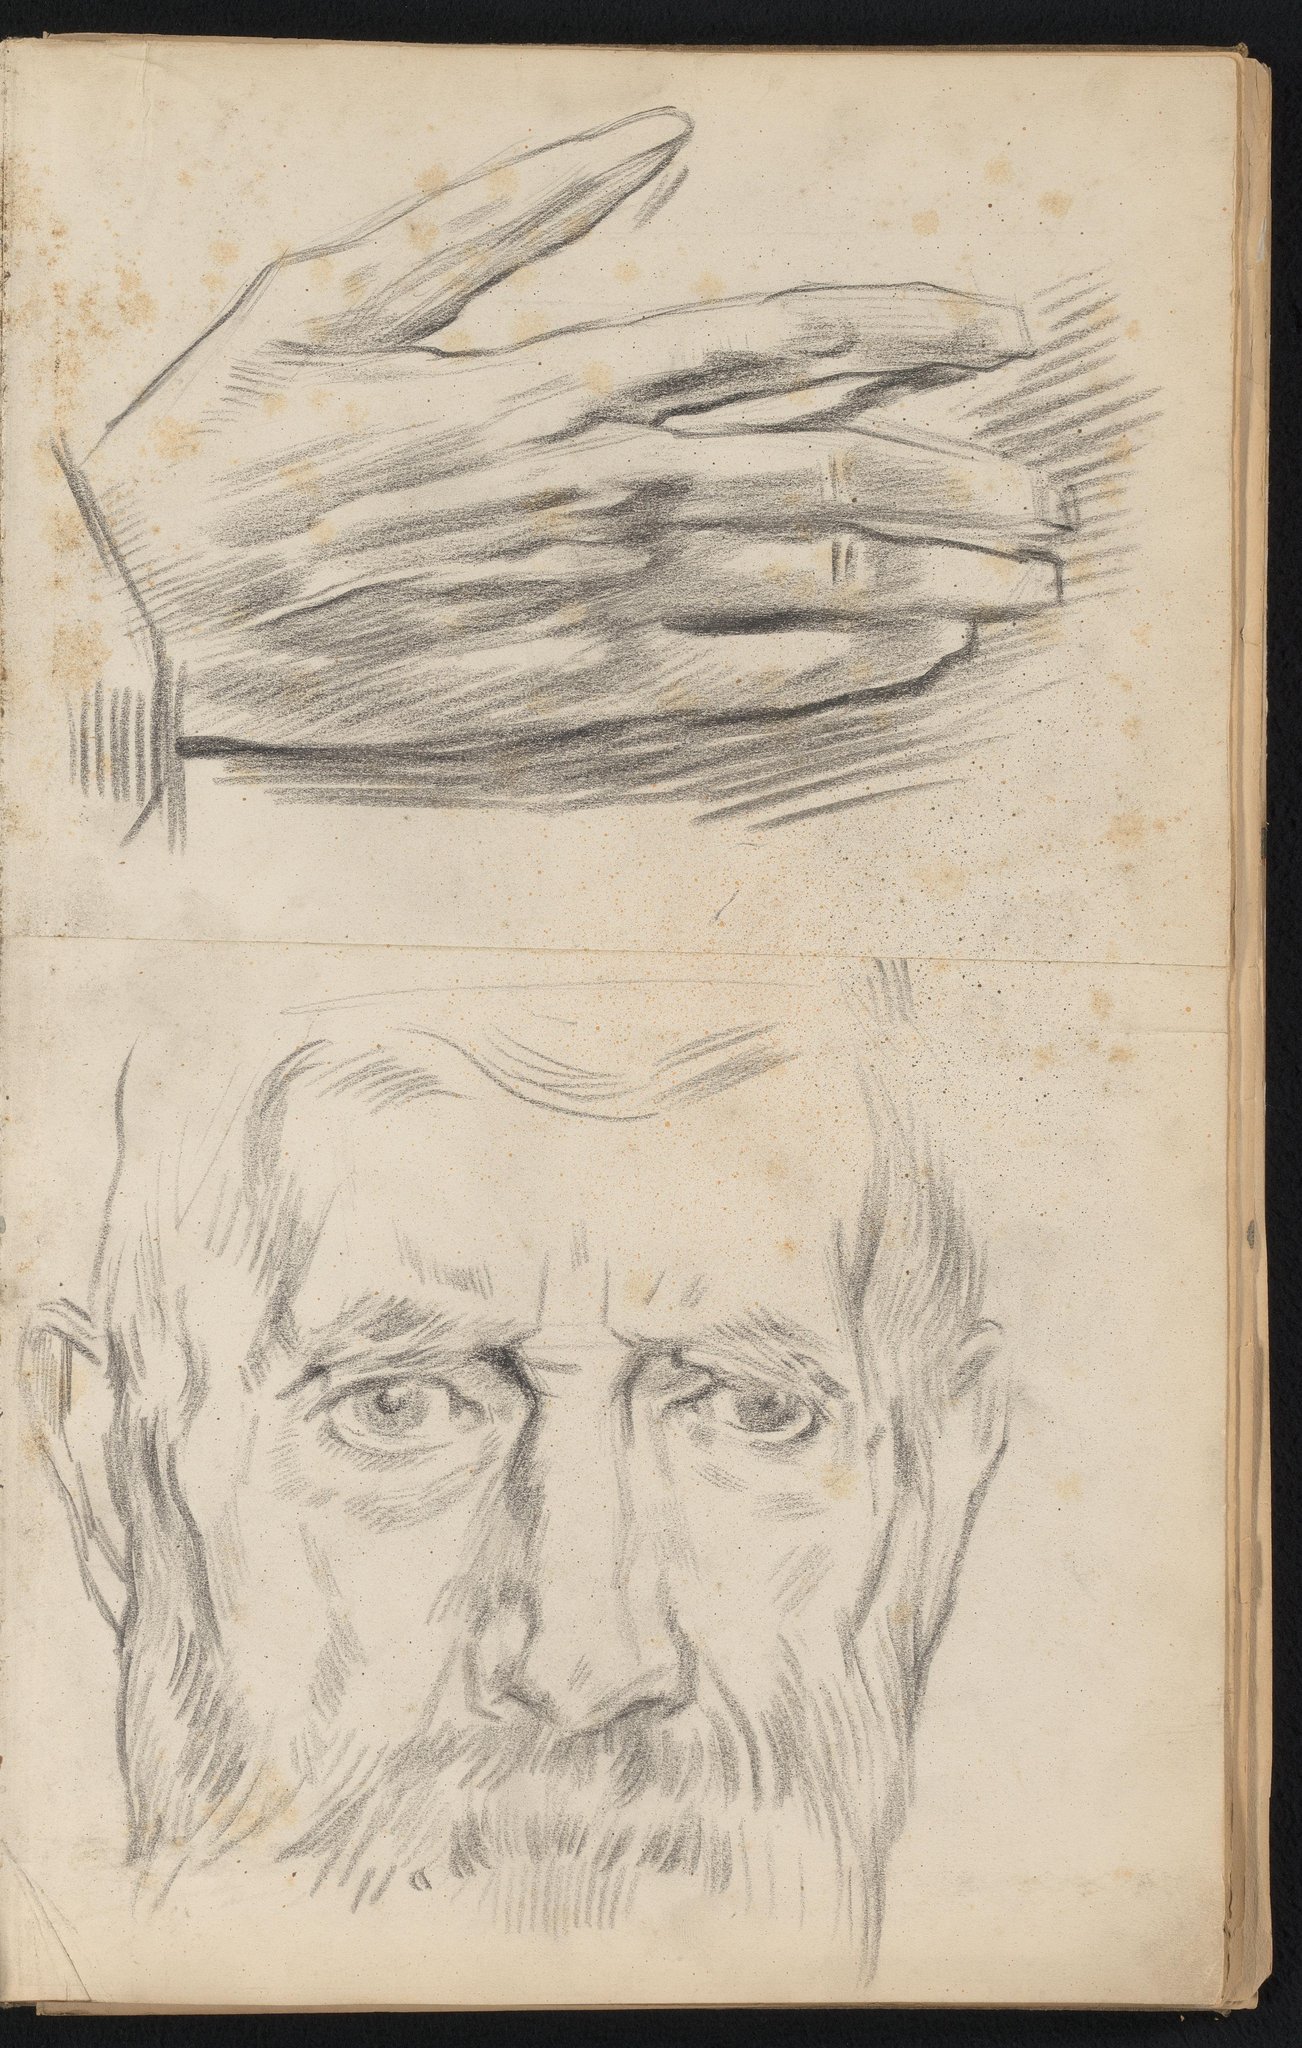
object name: sketchbook leaf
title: Hand en een portret van een man met een baard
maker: huib luns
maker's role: draughtsman, print maker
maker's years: 1881-1942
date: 1908-1909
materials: chalk, paper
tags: hand, anonymous historical person portrayed, beard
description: Blad 4 recto uit een schetsboek met 24 bladen.